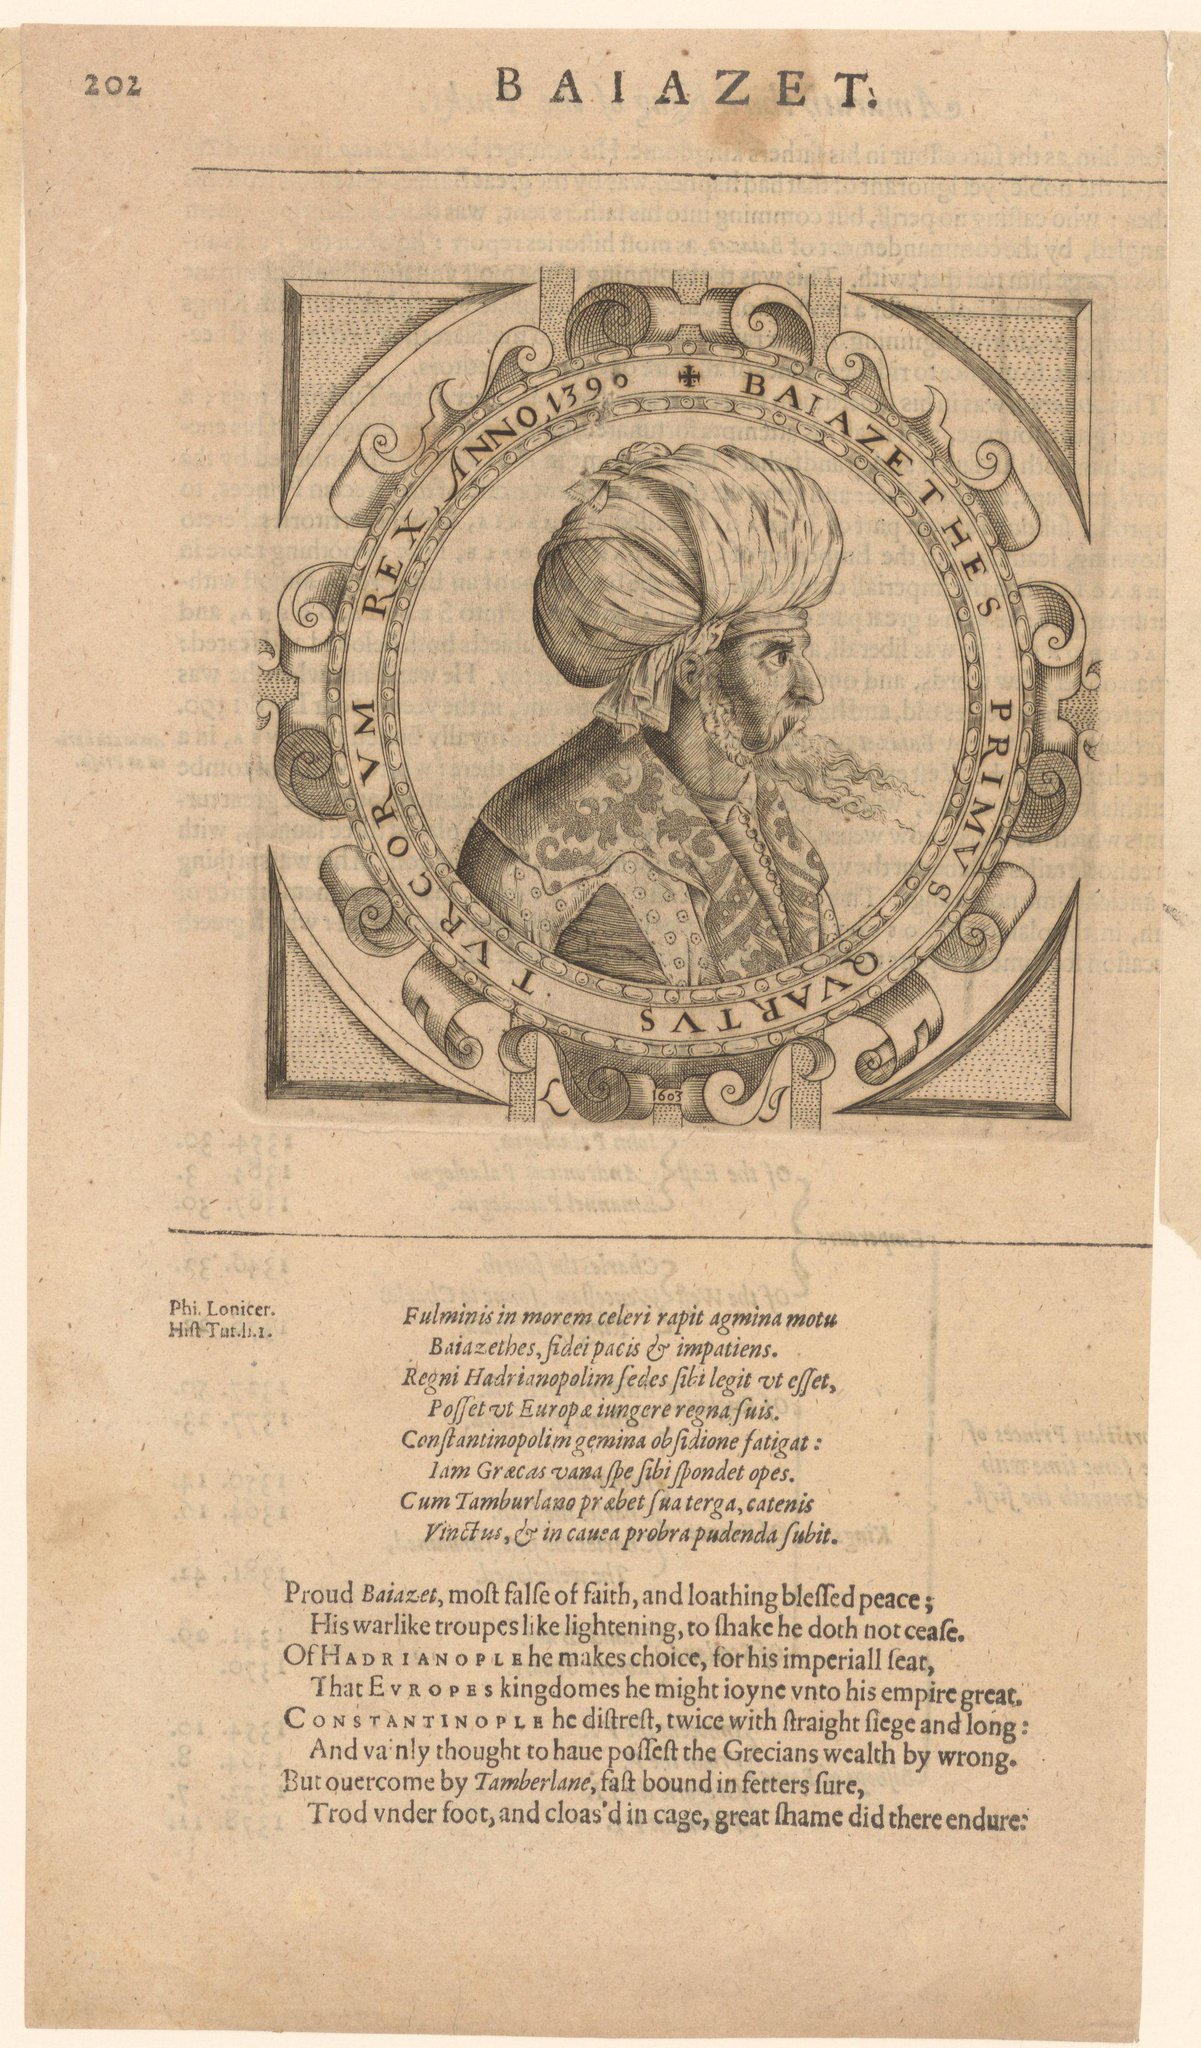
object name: print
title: Portret van sultan Bayezid I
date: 1603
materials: paper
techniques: engraving, letterpress printing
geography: london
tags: historical persons, ruler, sovereign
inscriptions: collector's mark: Lugt 2228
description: Prent gebruikt in: Knolles, Richard. The lives of the Othoman Kings and Emperors (...). Londen: Adam Islip, 1603. Prent ook gebruikt in: Knolles, Richard. The Generall Historie of the Turkes from the First Beginning of that Nation to the Rising of the Othoman Familie. Londen: Adam Islip, 1603.